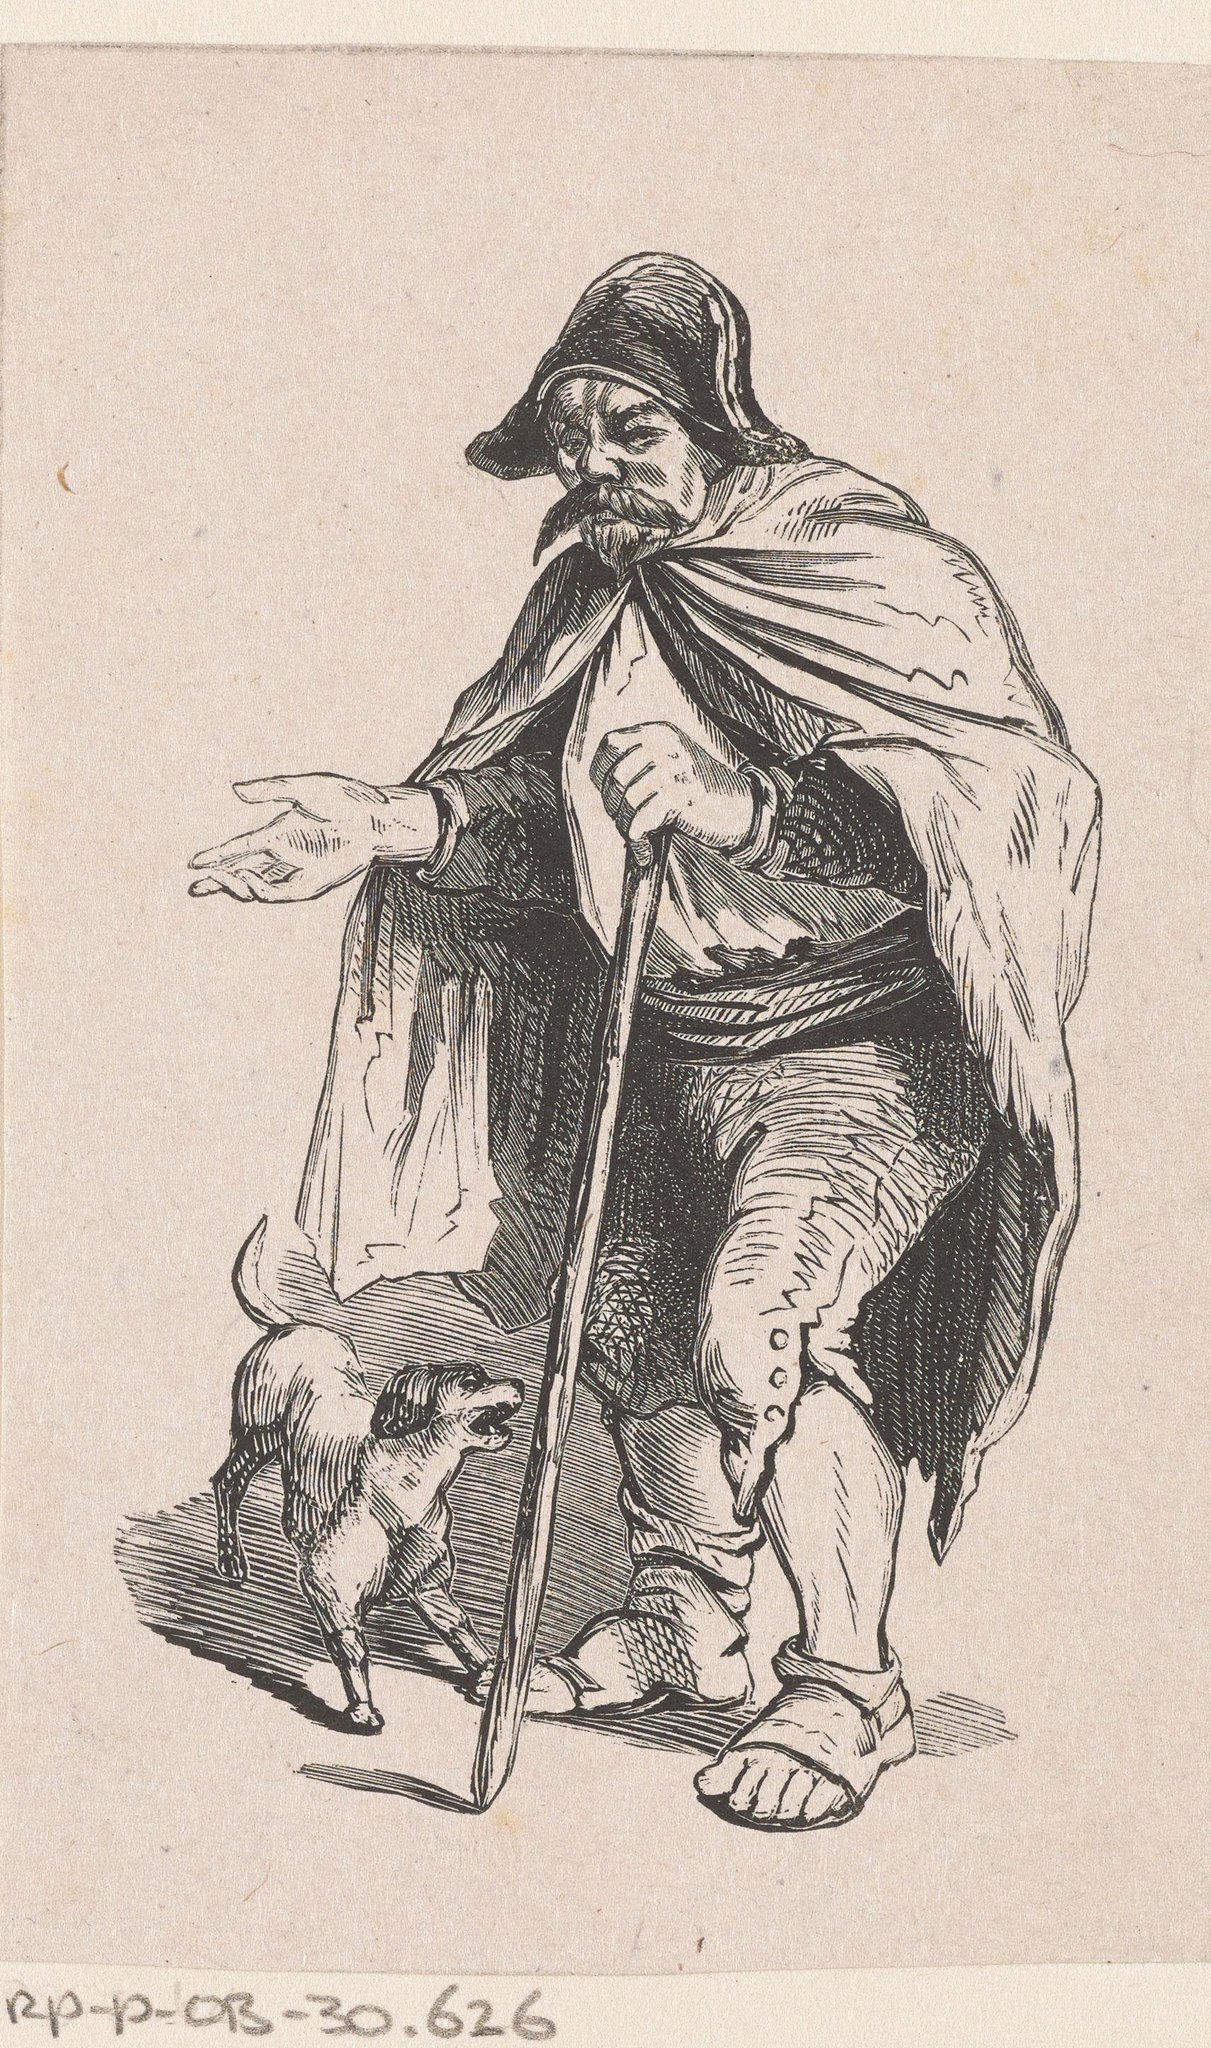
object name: print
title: Staande man met een stok en een hond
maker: isaac weissenbruch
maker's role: print maker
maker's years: 1826-1912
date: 1836-1912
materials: paper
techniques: engraving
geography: netherlands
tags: walking-stick, staff, adult man (+ standing), dog